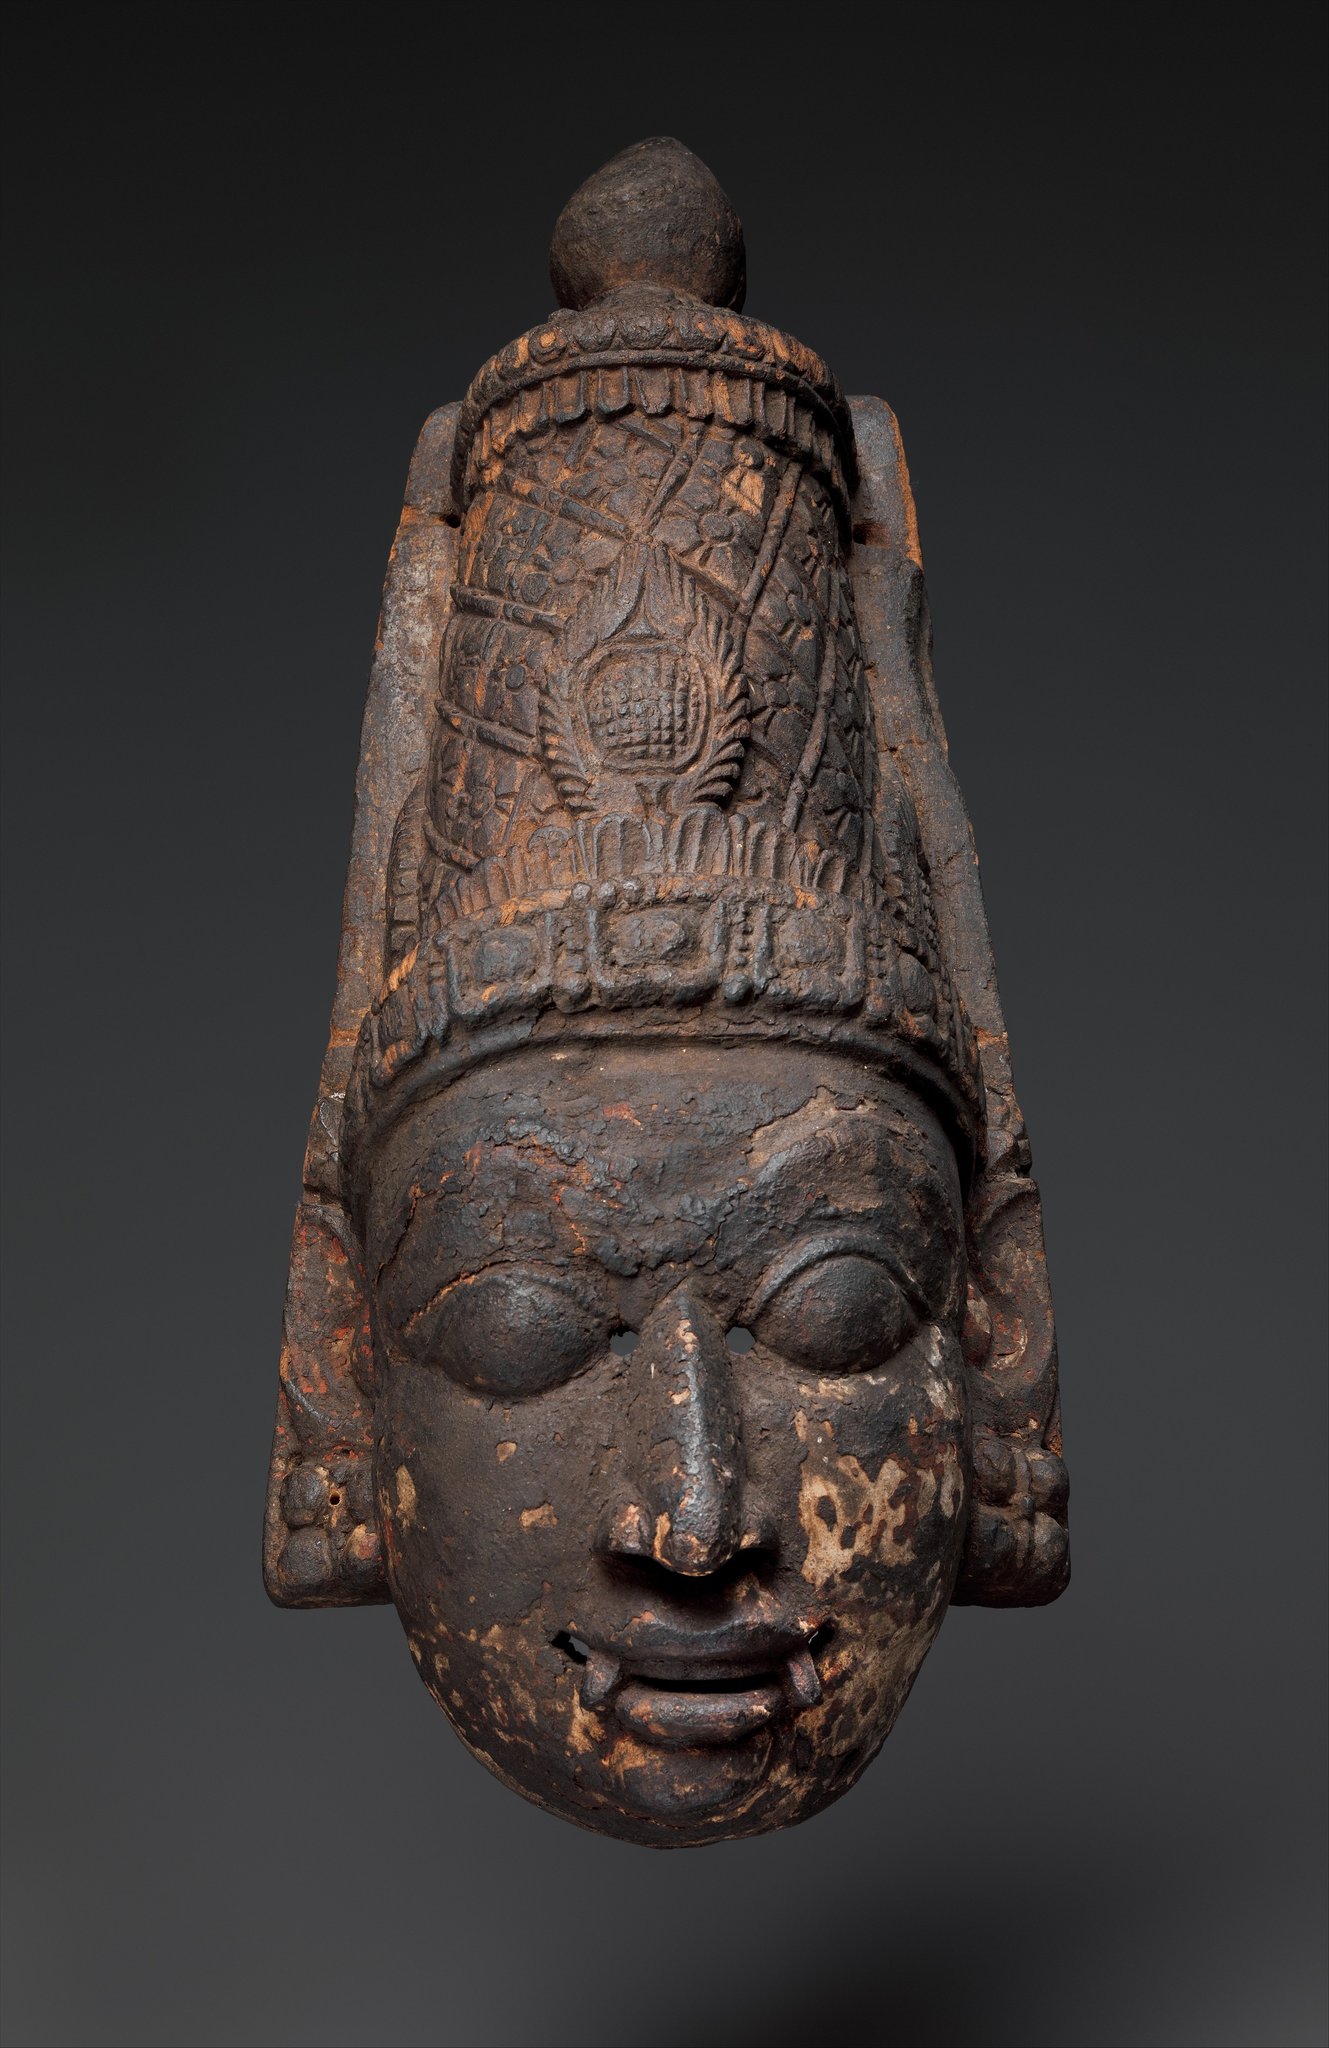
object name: mask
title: Hiranyakashipu, The Demon-King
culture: indian, southern, tamil nadu, thanjavur district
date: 1700-1750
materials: textile, wood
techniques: polychrome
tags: kings